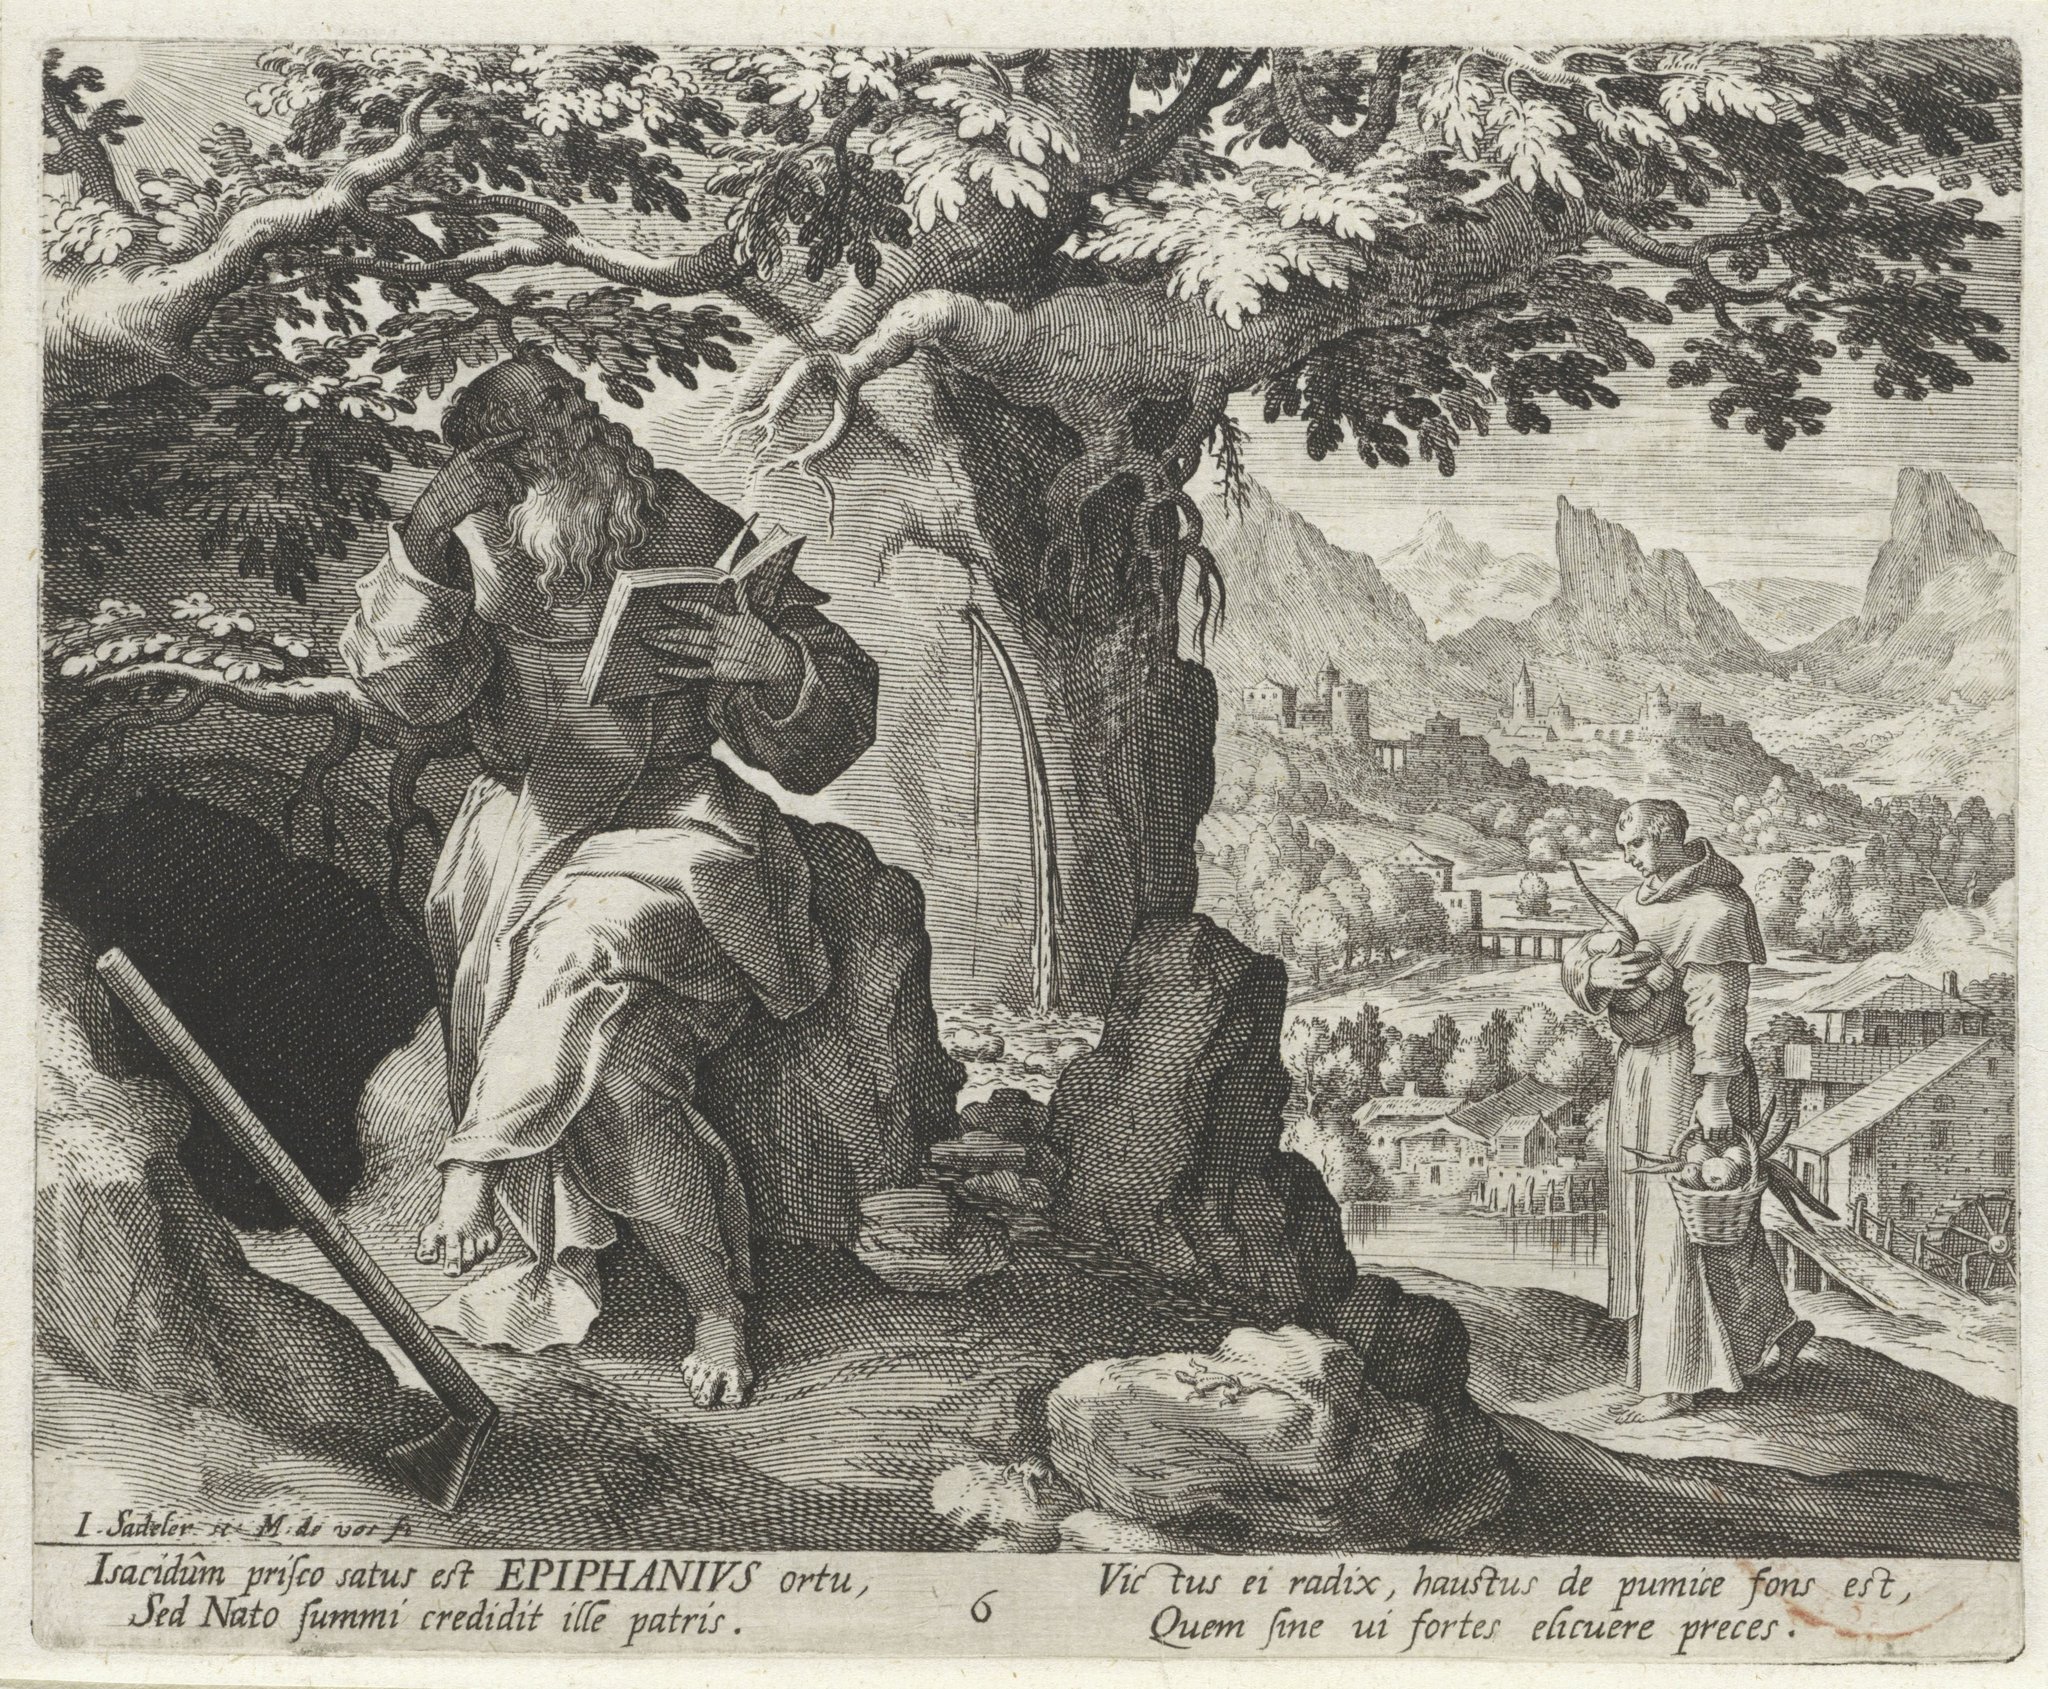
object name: print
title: Epiphanius als kluizenaar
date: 1594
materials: paper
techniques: engraving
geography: munich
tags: male saints (ephiphanius of salamis), anchorite, hermit, cave, grotto, spring, source of river or stream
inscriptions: collector's mark: Lugt 240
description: De H. Epiphanius, de bisschop van Salamis, als een vroeg-christelijke kluizenaar. Hij zit voor een grot in een bergachtig landschap. Hij leest een bijbel. Achter hem ontspringt een bron uit de wand van de grot. Op de achtergrond rechts een monnik met een groentemand.